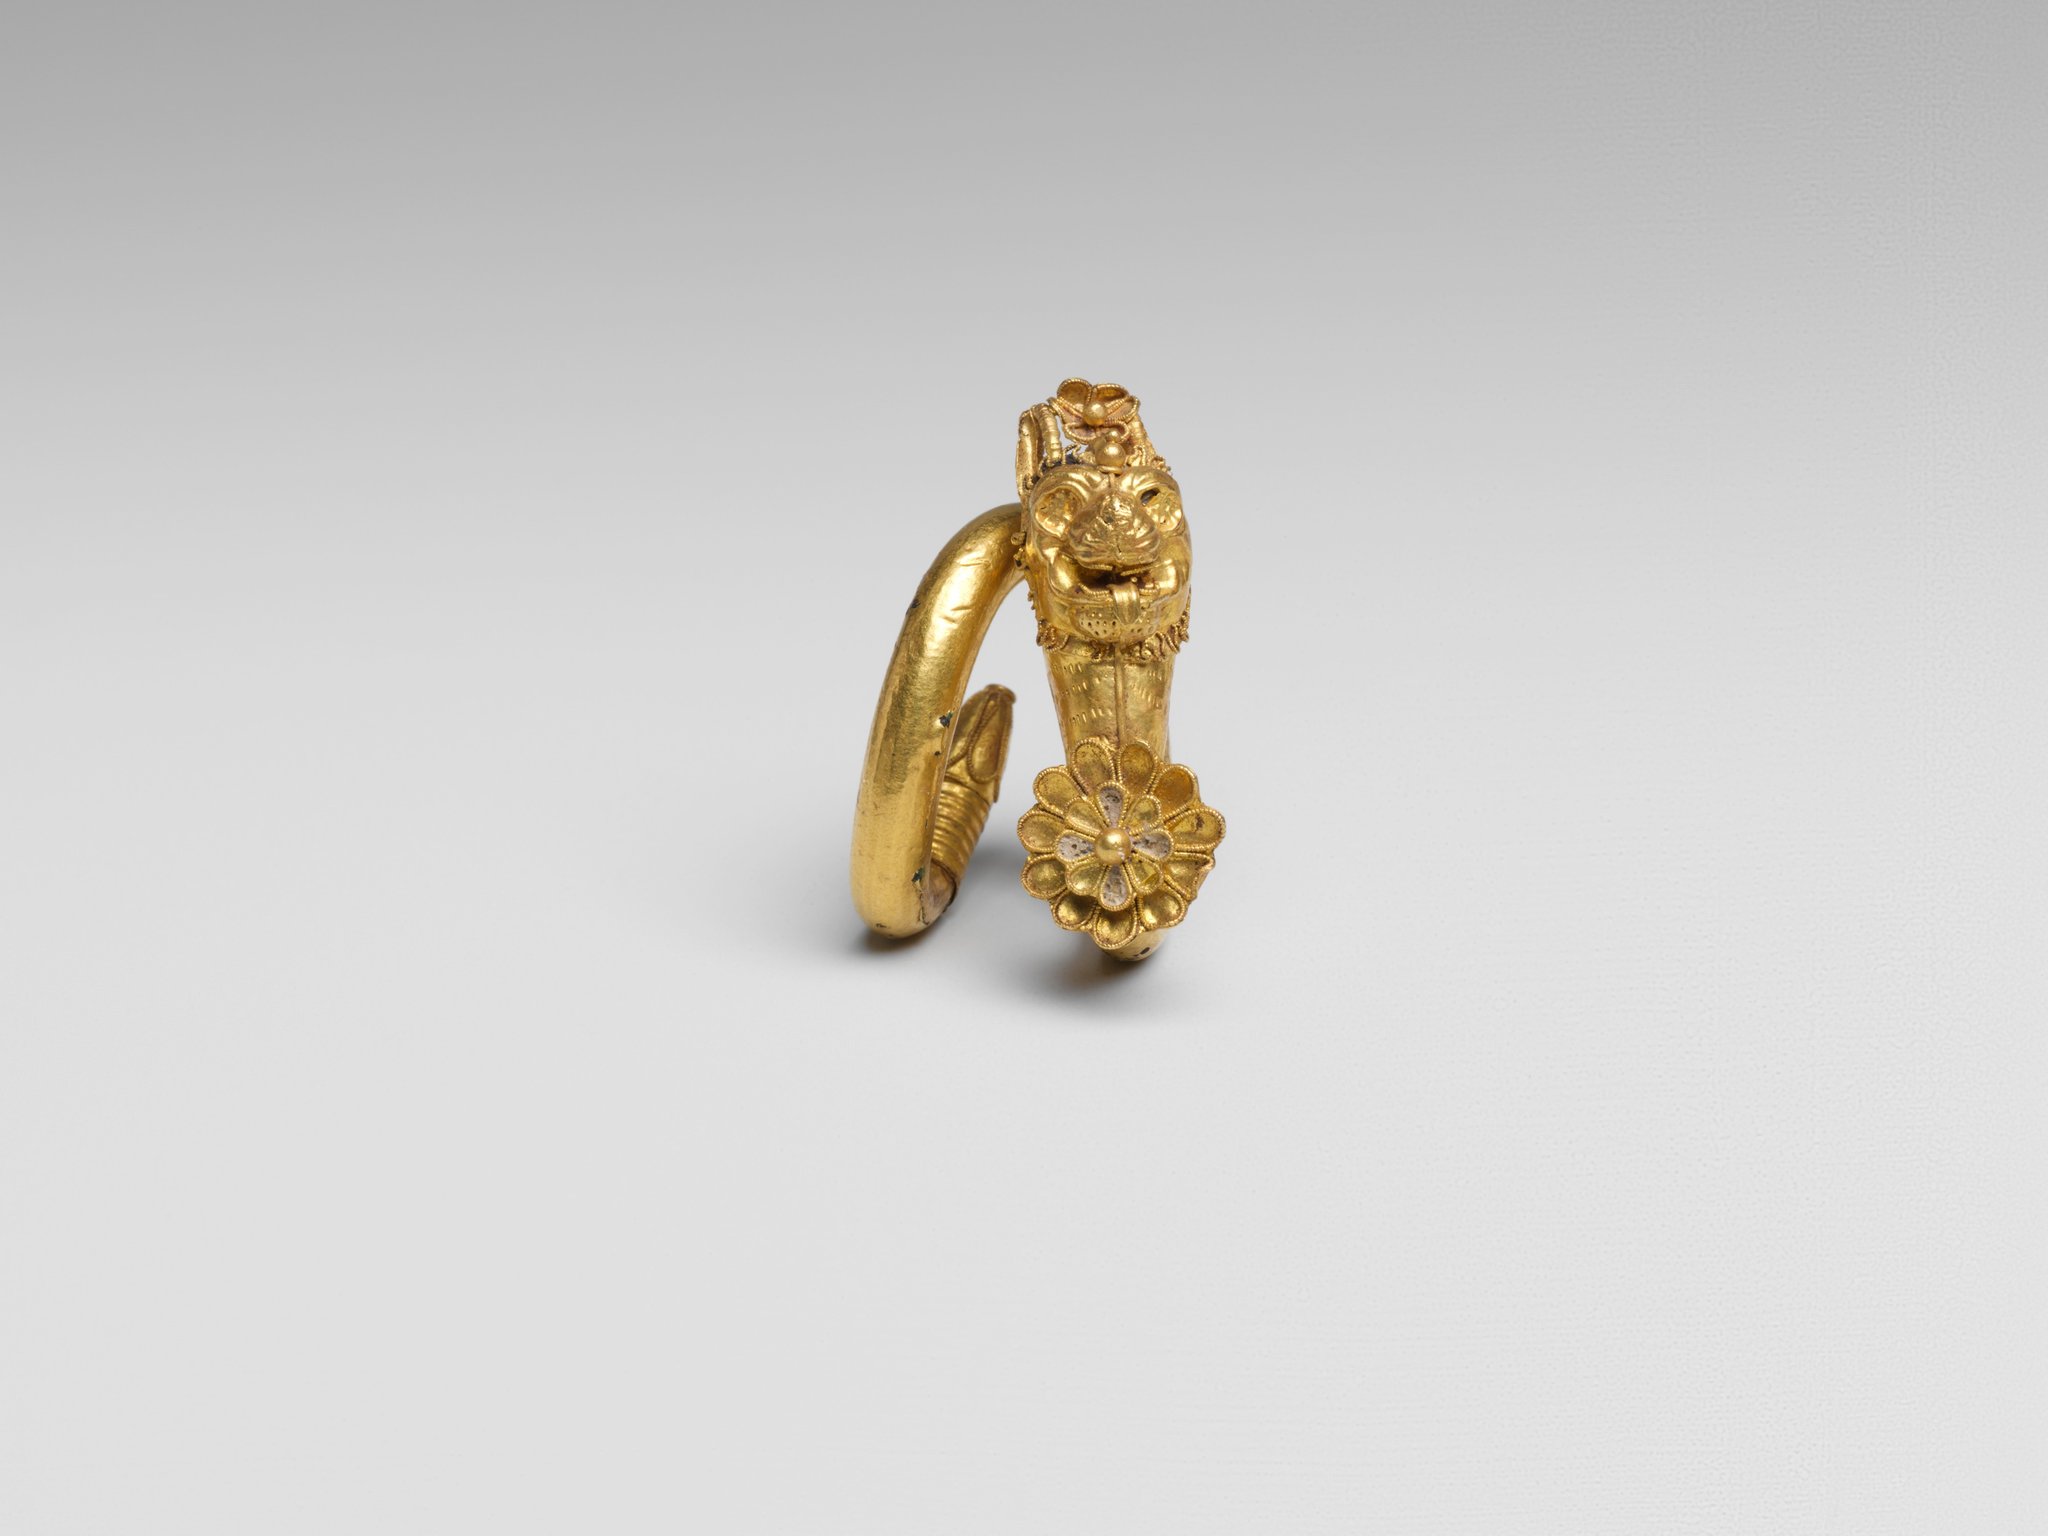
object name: earring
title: Gilt bronze spiral with lion-griffin terminal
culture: greek, cypriot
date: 400-350 BCE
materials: gold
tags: lions